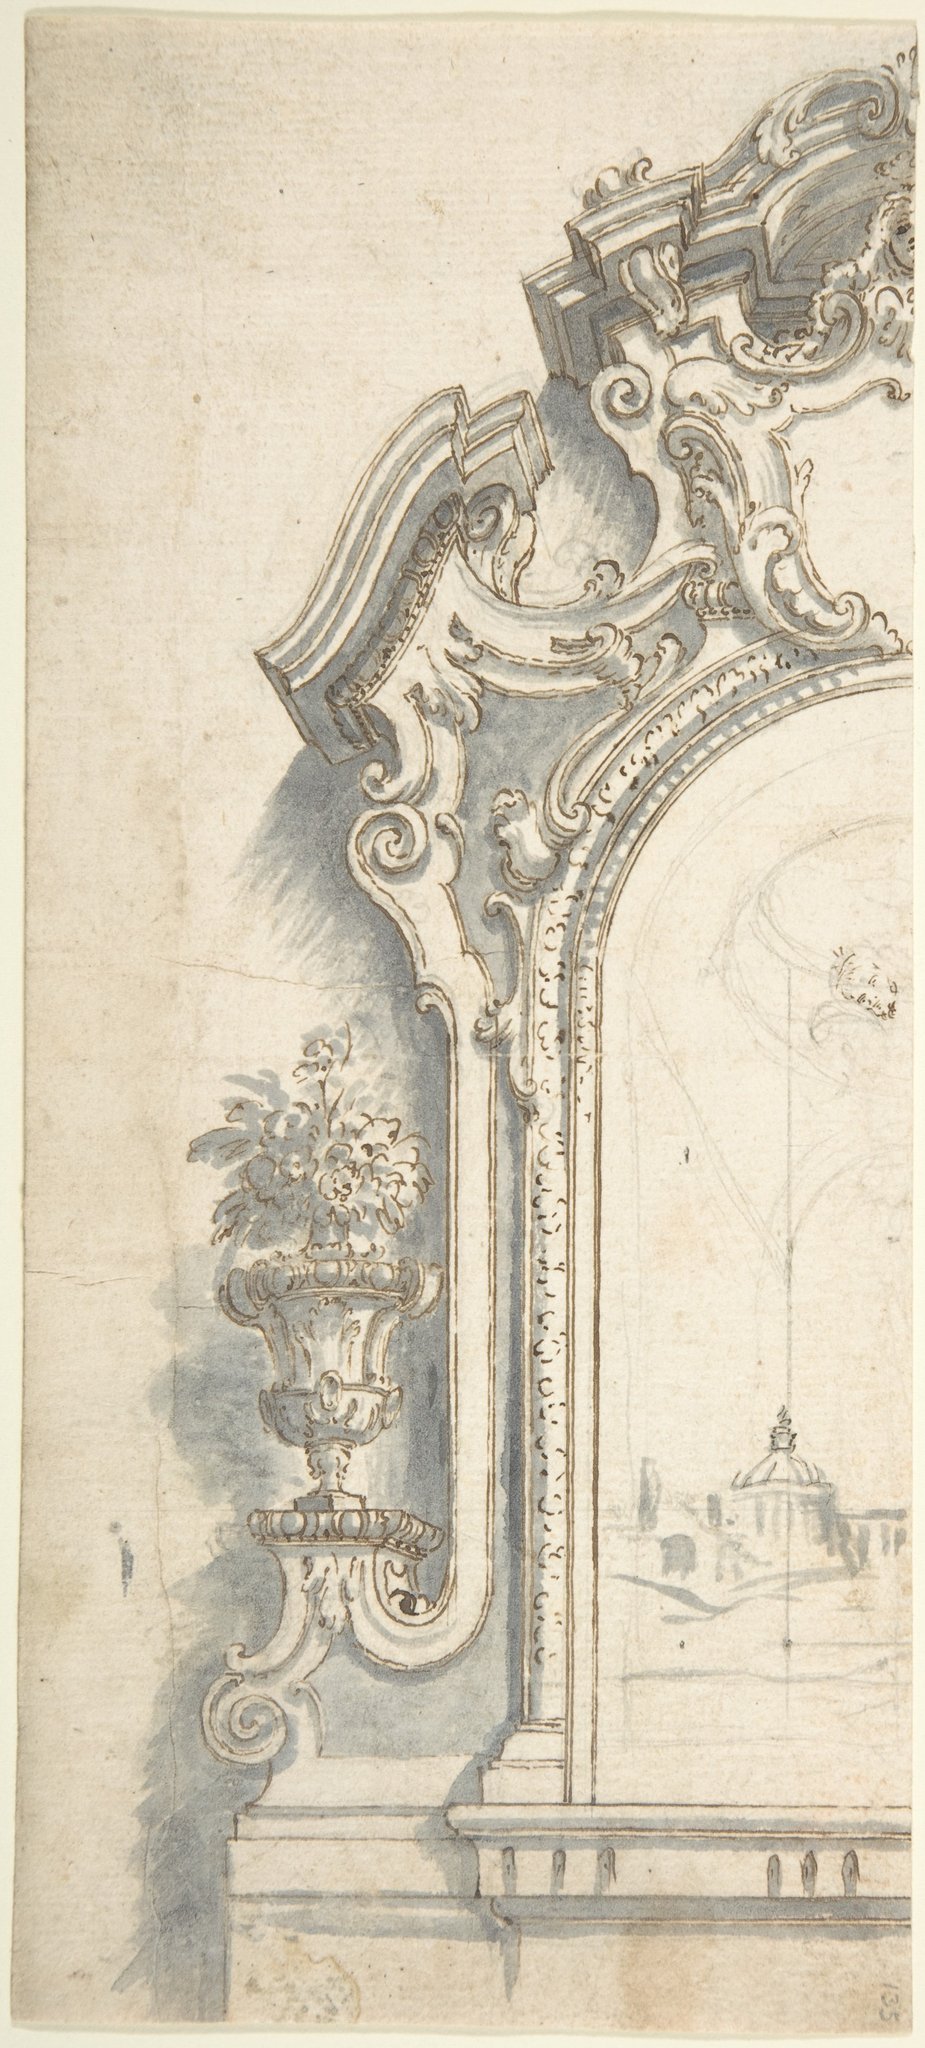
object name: drawing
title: Design for Left Side of an Altarpiece Frame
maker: anonymous, italian, piedmontese, 18th century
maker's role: artist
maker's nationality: italian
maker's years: 1700-1800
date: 1700-1780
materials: graphite, ink, drawing material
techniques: brush, pen, wash